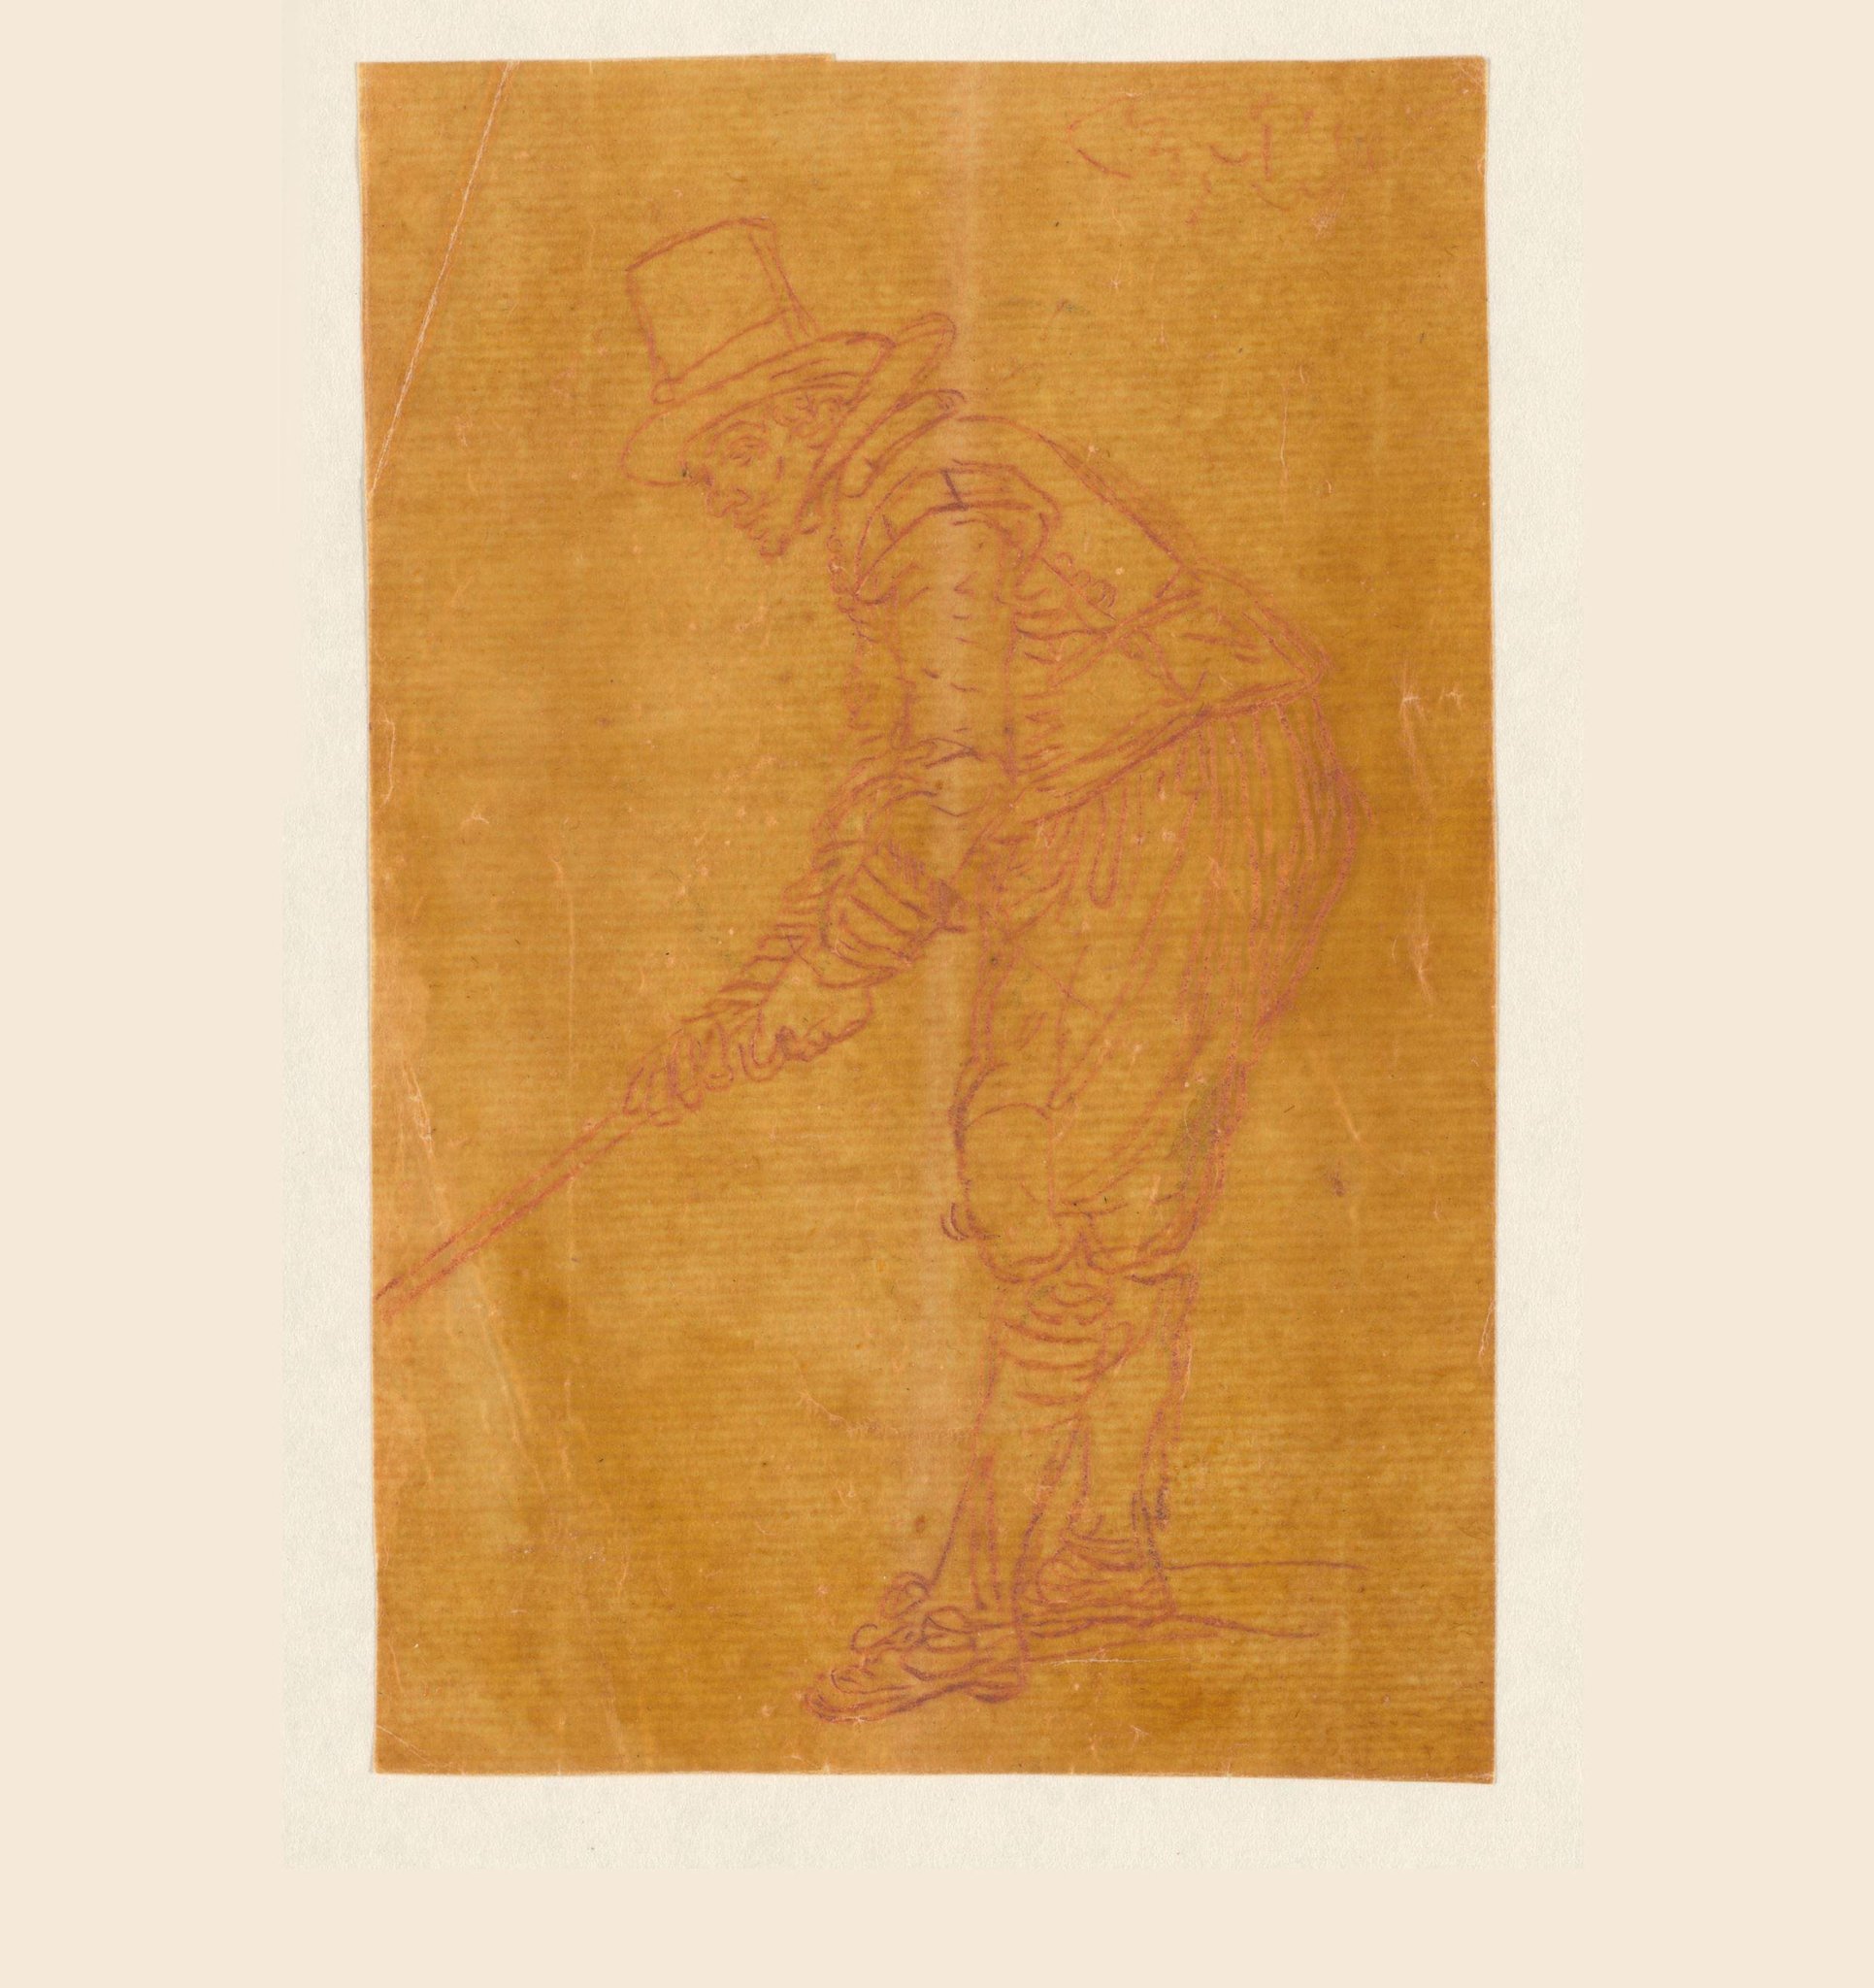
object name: drawing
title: Kolfspeler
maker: cornelis ploos van amstel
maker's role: draughtsman, print maker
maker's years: 1726-1798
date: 1758-1762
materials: chalk, paper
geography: amsterdam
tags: 'kolf' (ball game) (+ sportsman, player, etc.)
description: Over de calques van Ploos van Amstel zie LNP, p. 201.